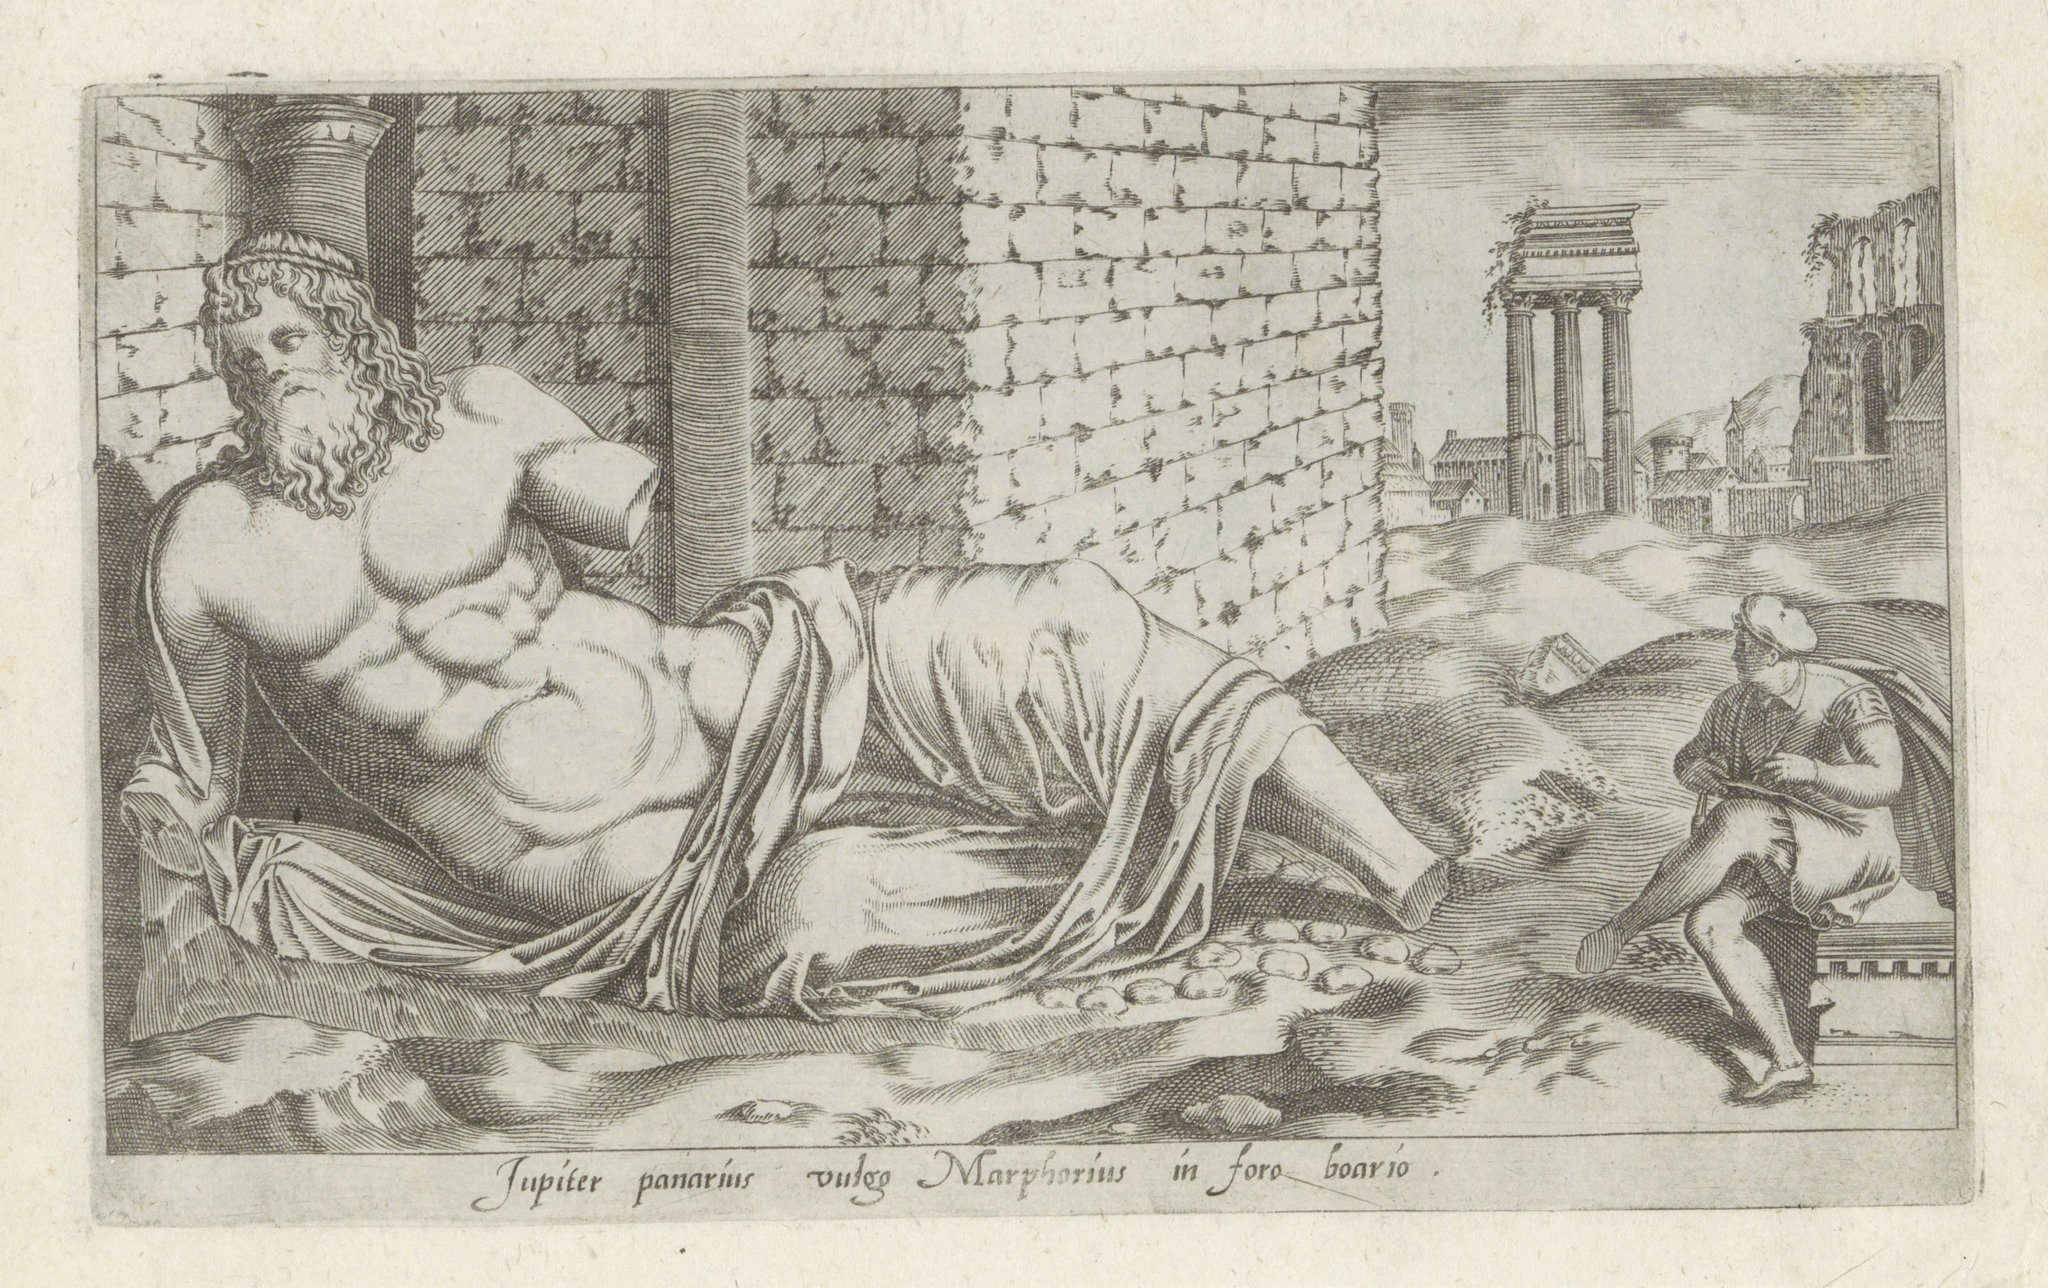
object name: album leaf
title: Antieke sculpturen in Rome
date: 1584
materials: paper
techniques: engraving, intaglio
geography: italy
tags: communication by means of 'statue parlanti', such as marforio and pasquino in rome, piece of sculpture, reproduction of a piece of sculpture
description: Sculptuur van Marforio, een van de pratende beelden in Rome. Onderschrift in het Latijn. Prent maakt deel uit van een album.